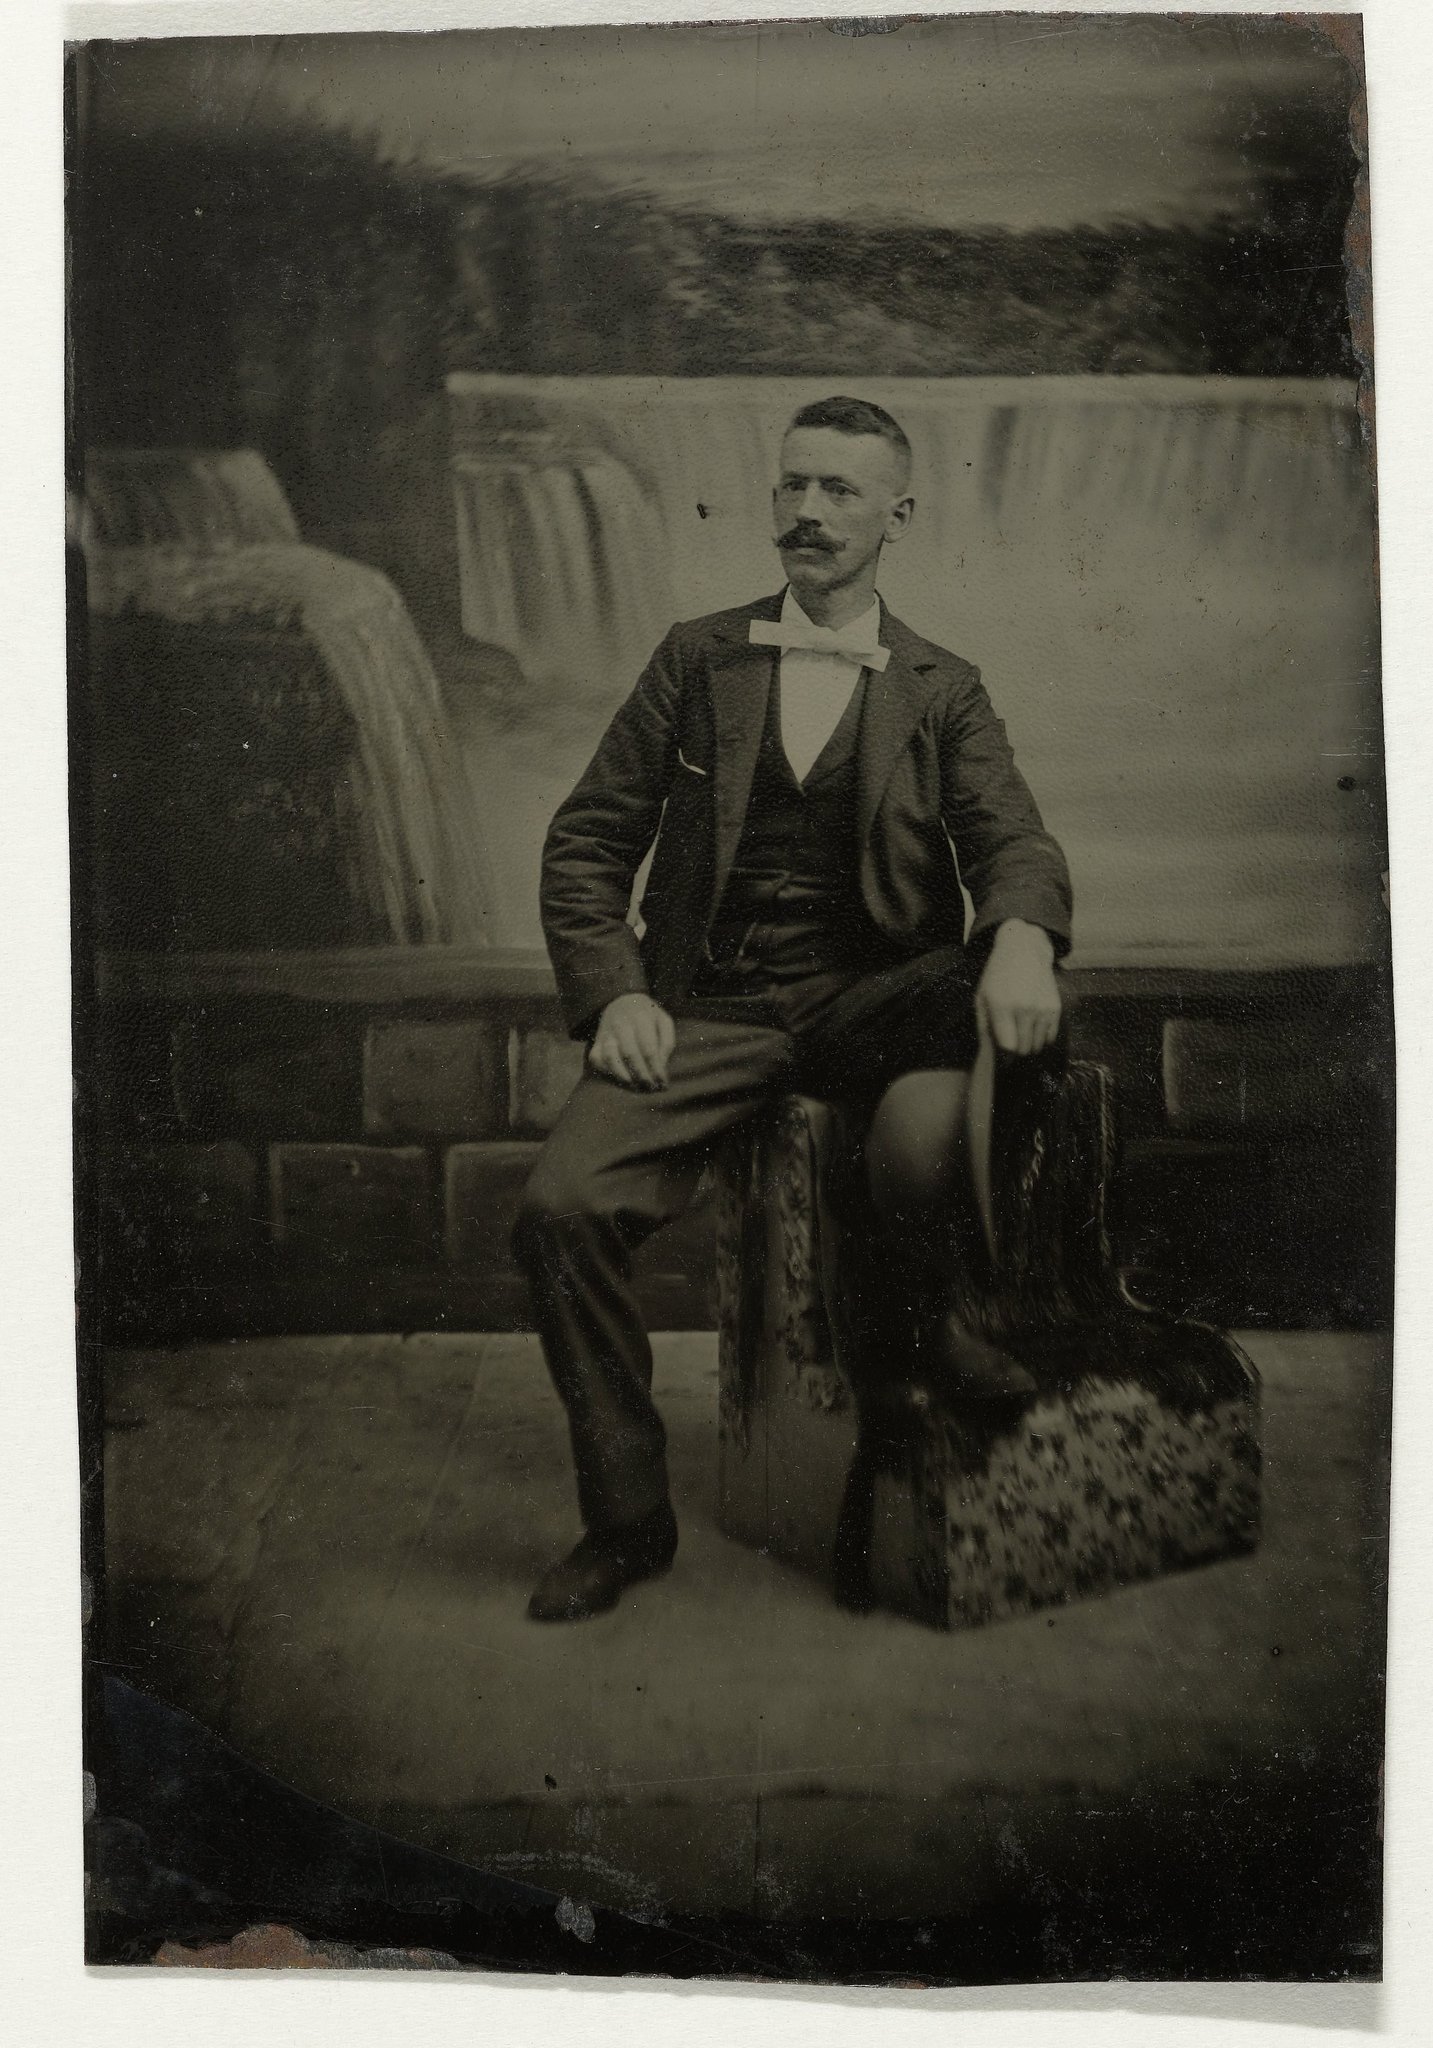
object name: photograph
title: Portret van een man, poserend voor een geschilderd achtergronddoek met een voorstelling van de Niagara Falls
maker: Anonymous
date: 1880-1910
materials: metal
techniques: ferrotyping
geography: united states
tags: anonymous historical person portrayed